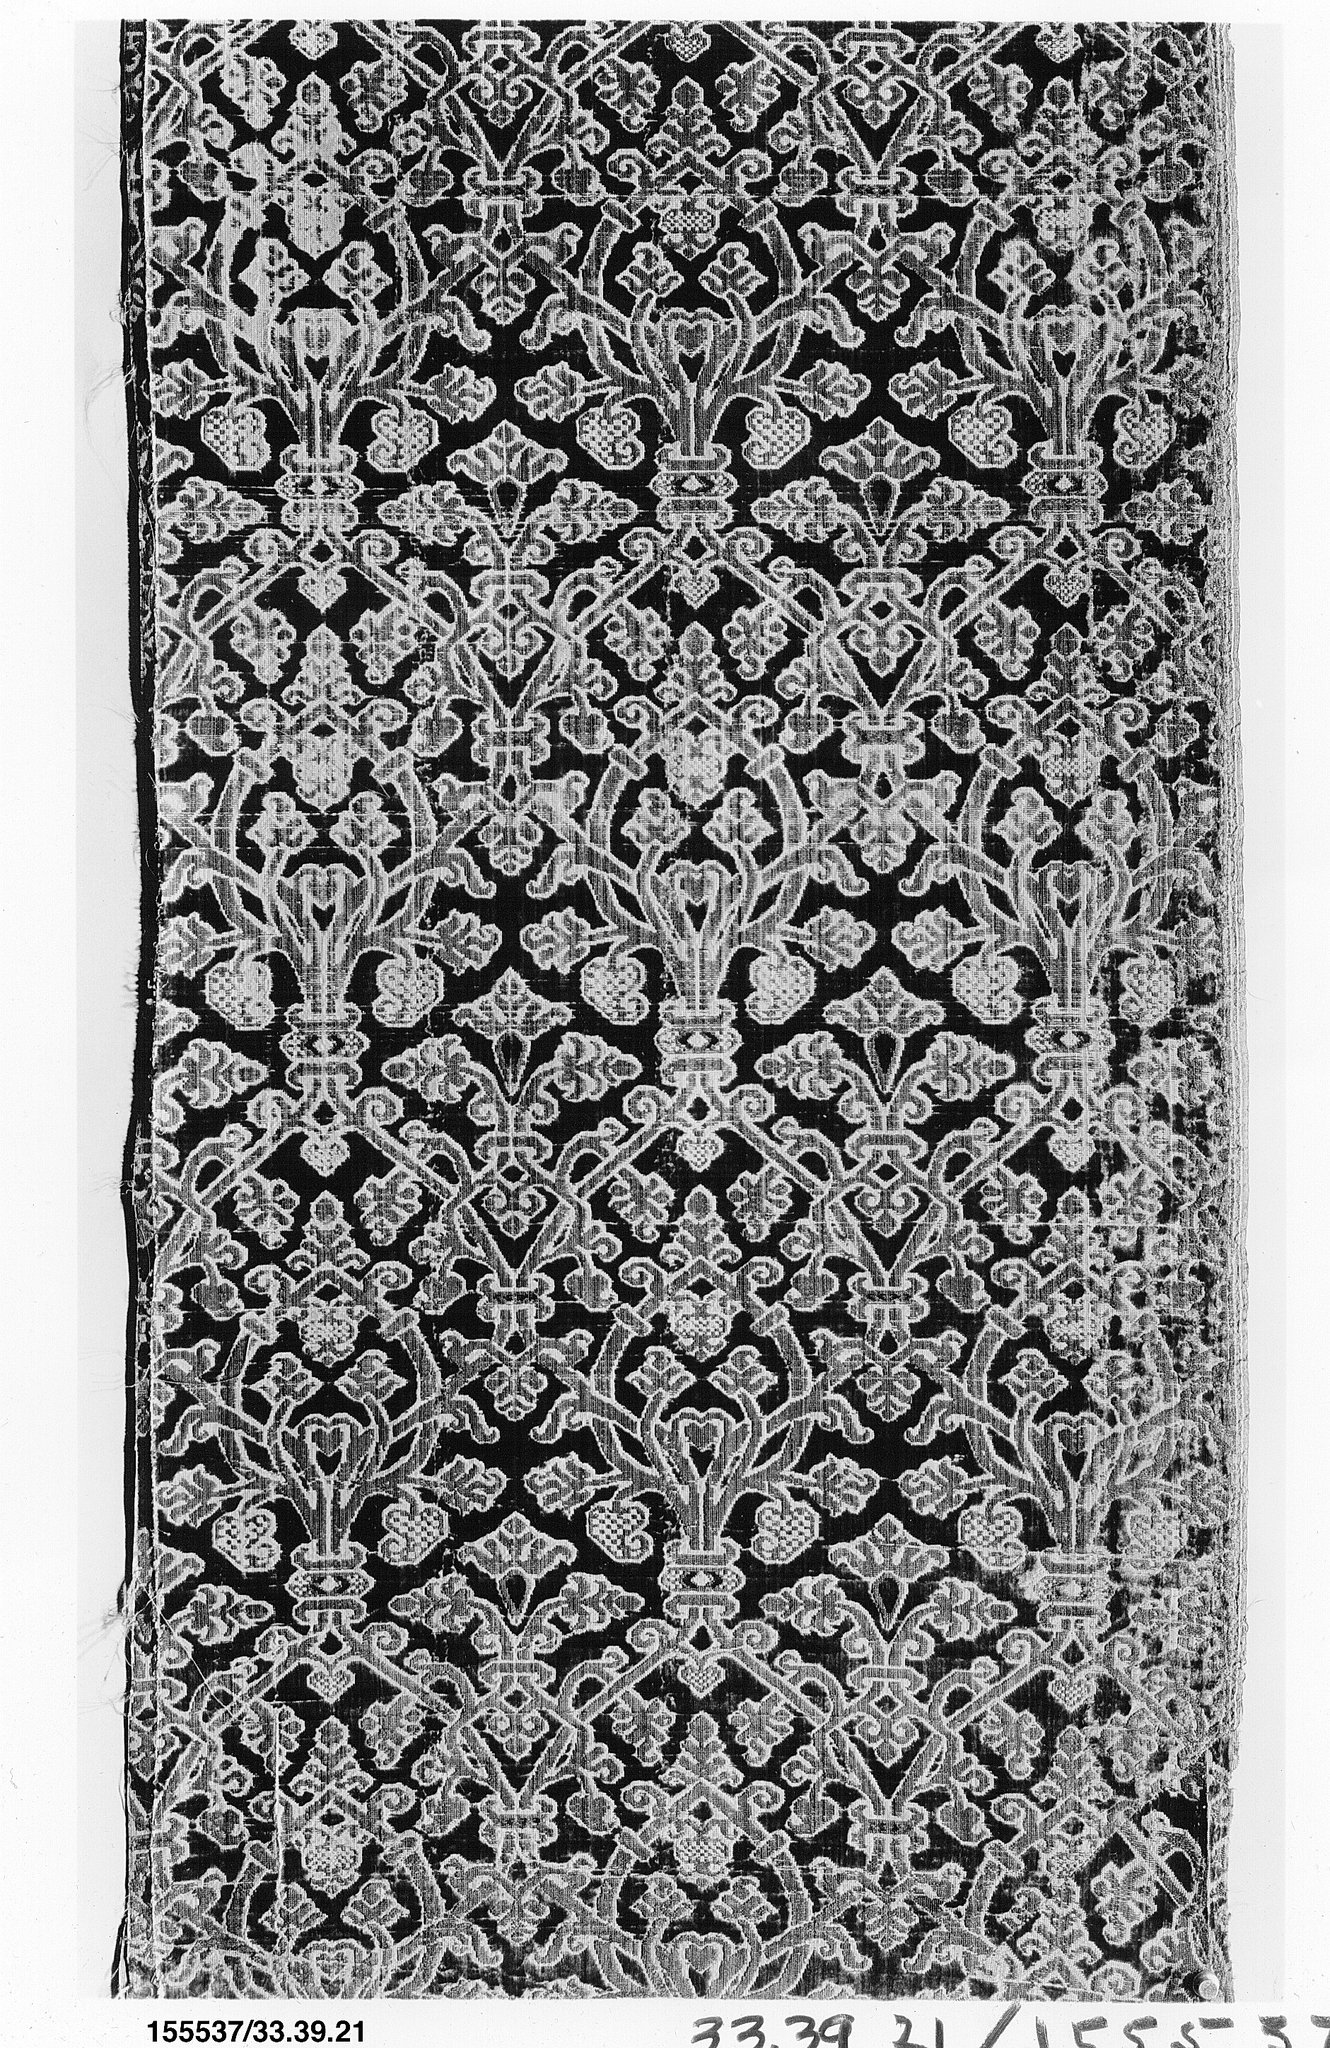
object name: piece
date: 1550-1599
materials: silk